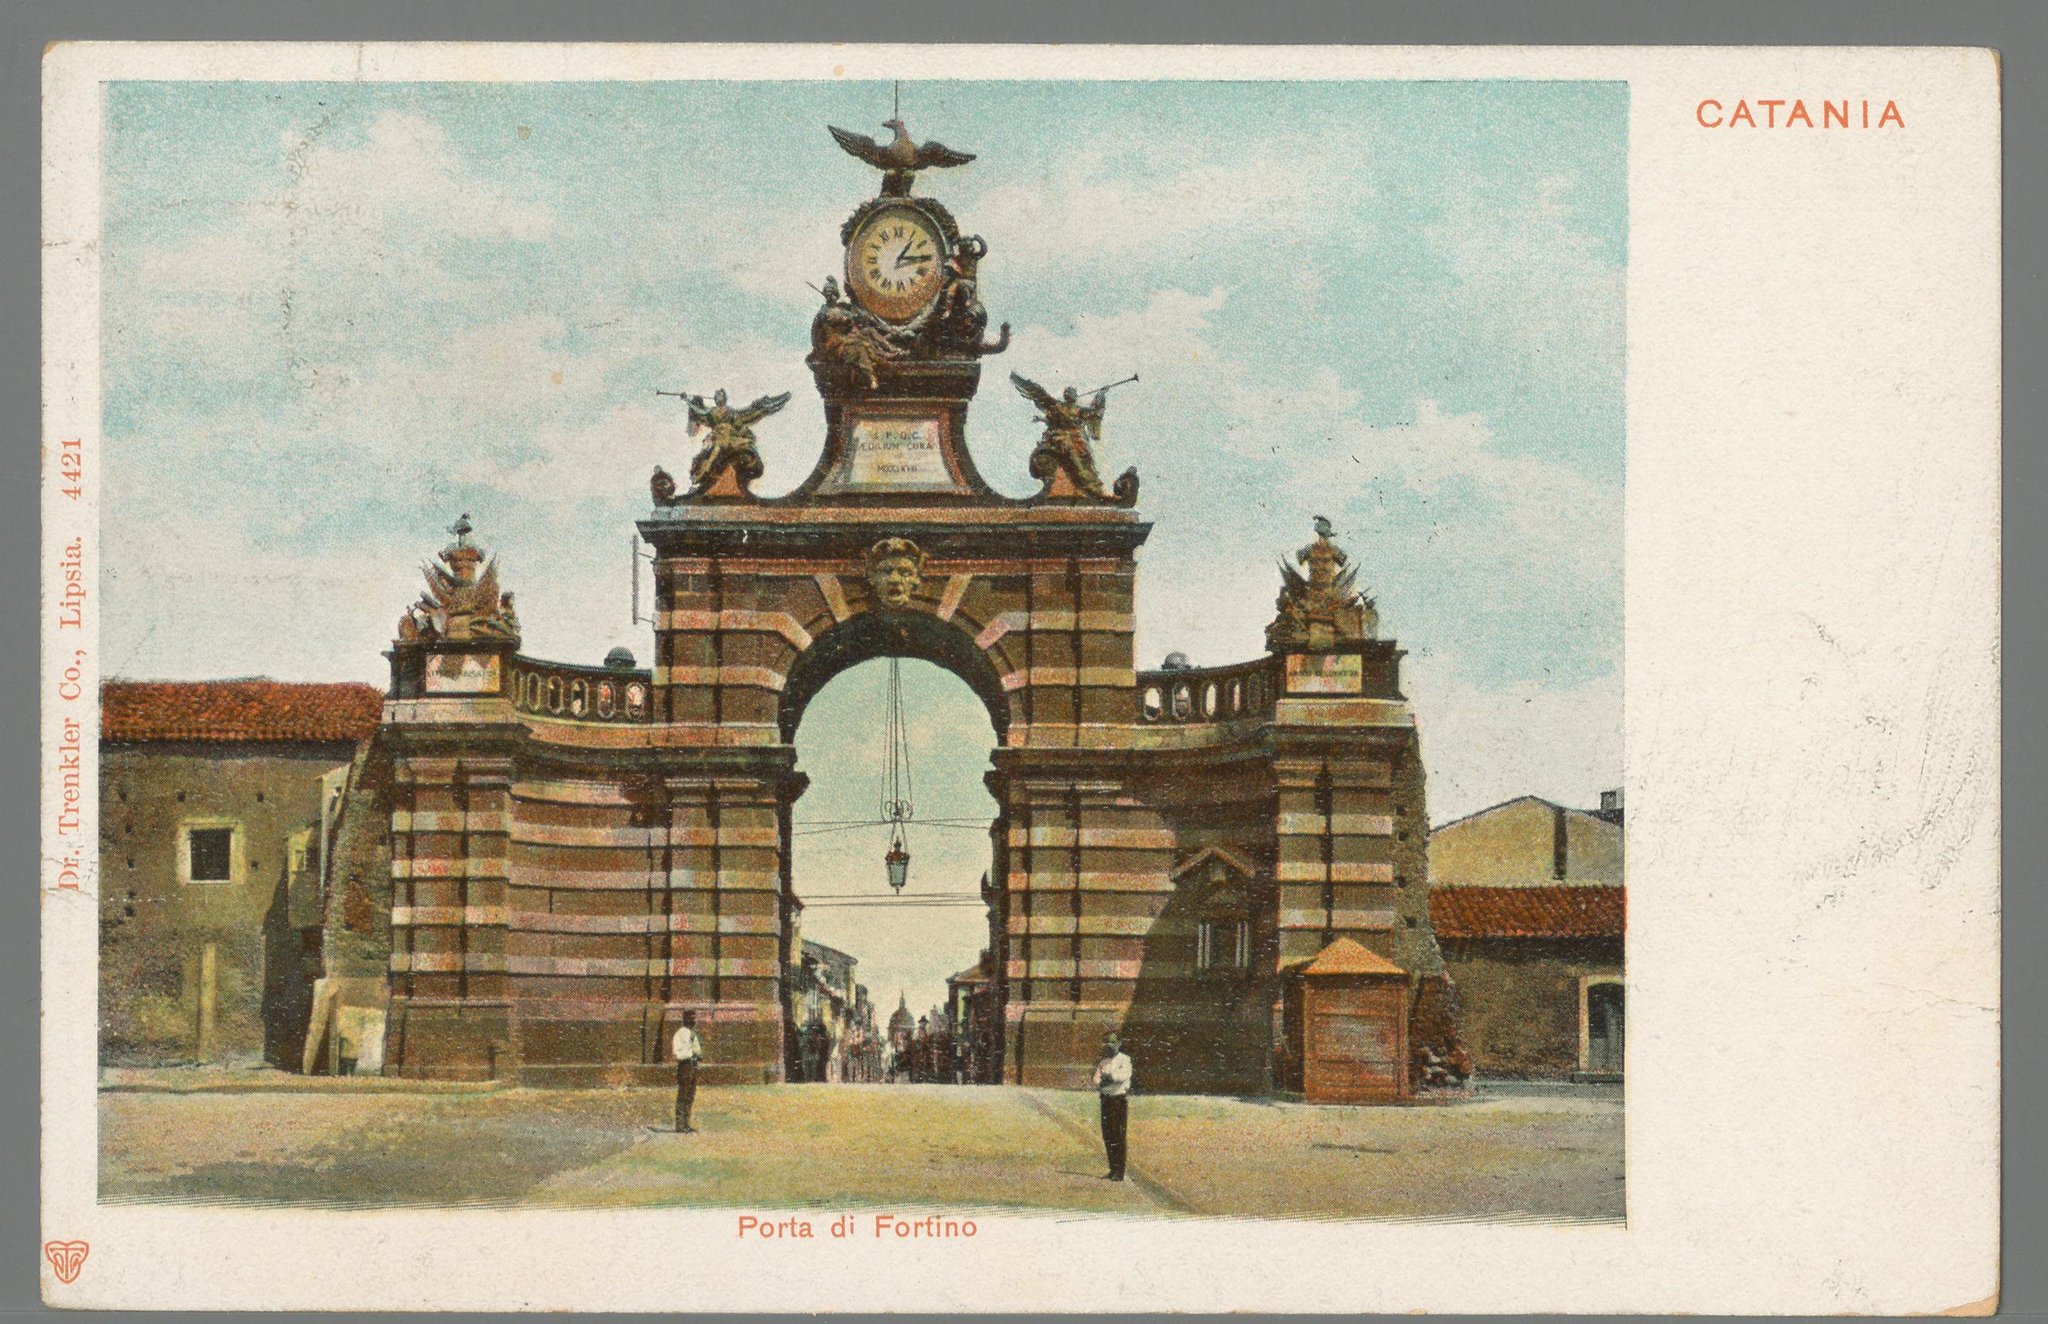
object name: ansichtkaart, prentbriefkaart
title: Catania. Porta di Fortino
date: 1885-1903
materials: cardboard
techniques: lithograph, writing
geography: catania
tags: square, place, circus, etc. (+ city(-scape) with figures, staffage), city-gate (+ city(-scape) with figures, staffage)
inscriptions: postage stamp